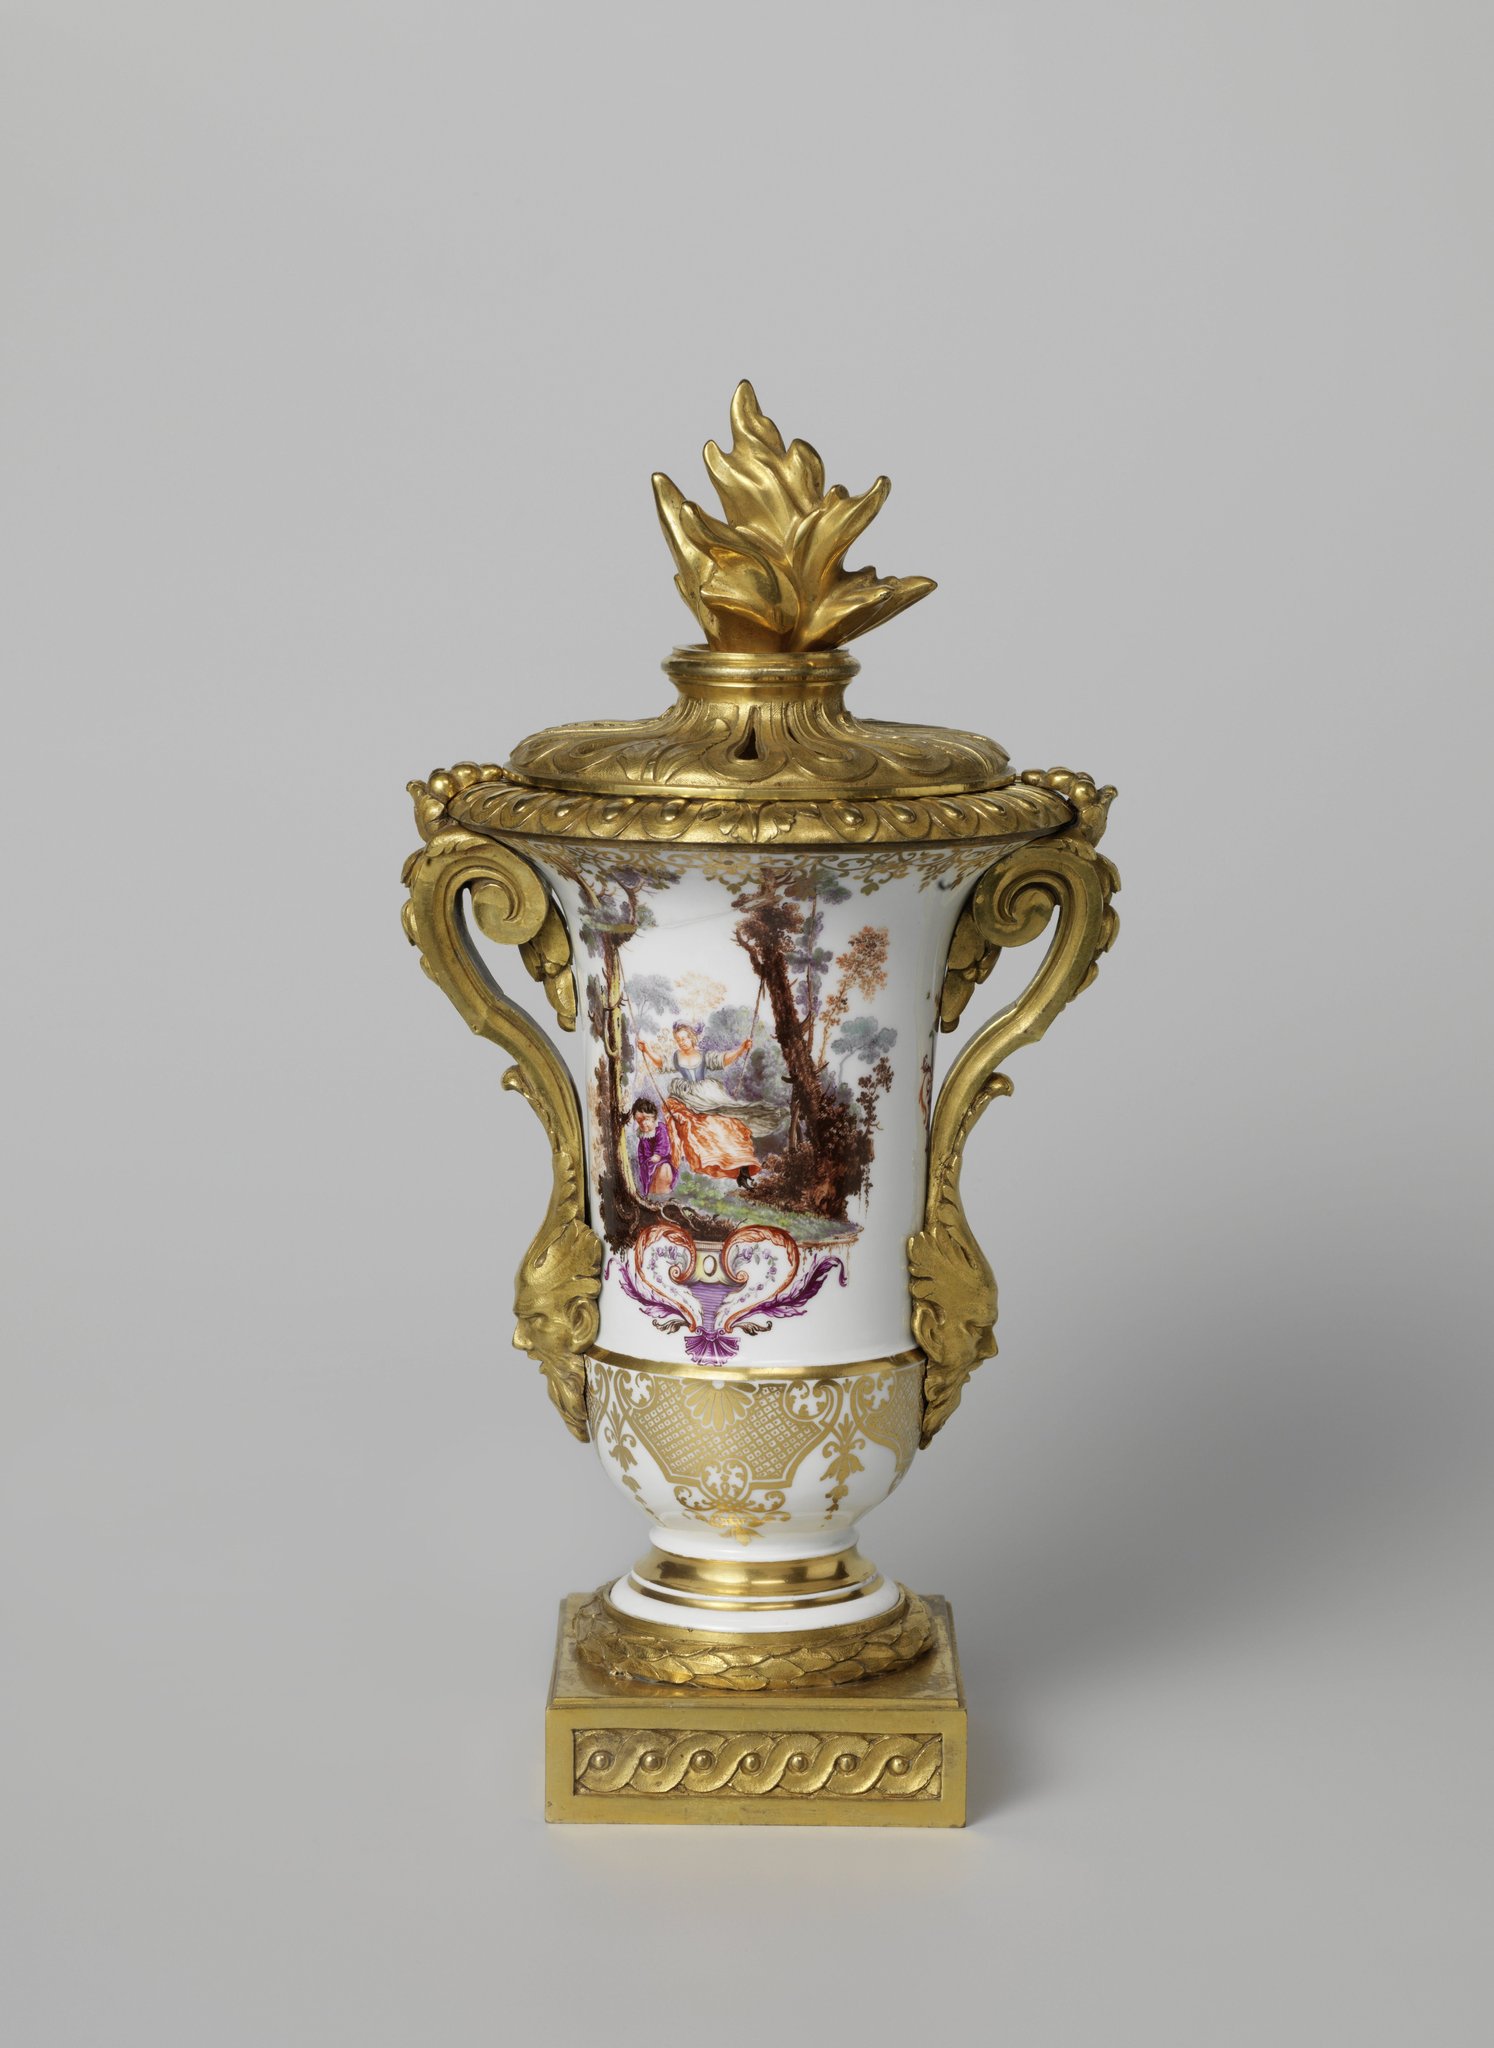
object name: vase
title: Three vases, part of a garniture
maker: johann christoph leibnitz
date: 1735-1740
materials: bronze, porcelain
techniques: gilding, painted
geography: meissen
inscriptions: mold mark: ‘XII (Rückert 1996, afb. 6, nr. 40)’, factory mark: ‘AR’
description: Meissener Porzellan Manufaktur after paintings by Jean Antoine Watteau (1684–1721) Meissen, c. 1735–1740 hard-paste porcelain, gilt bronze